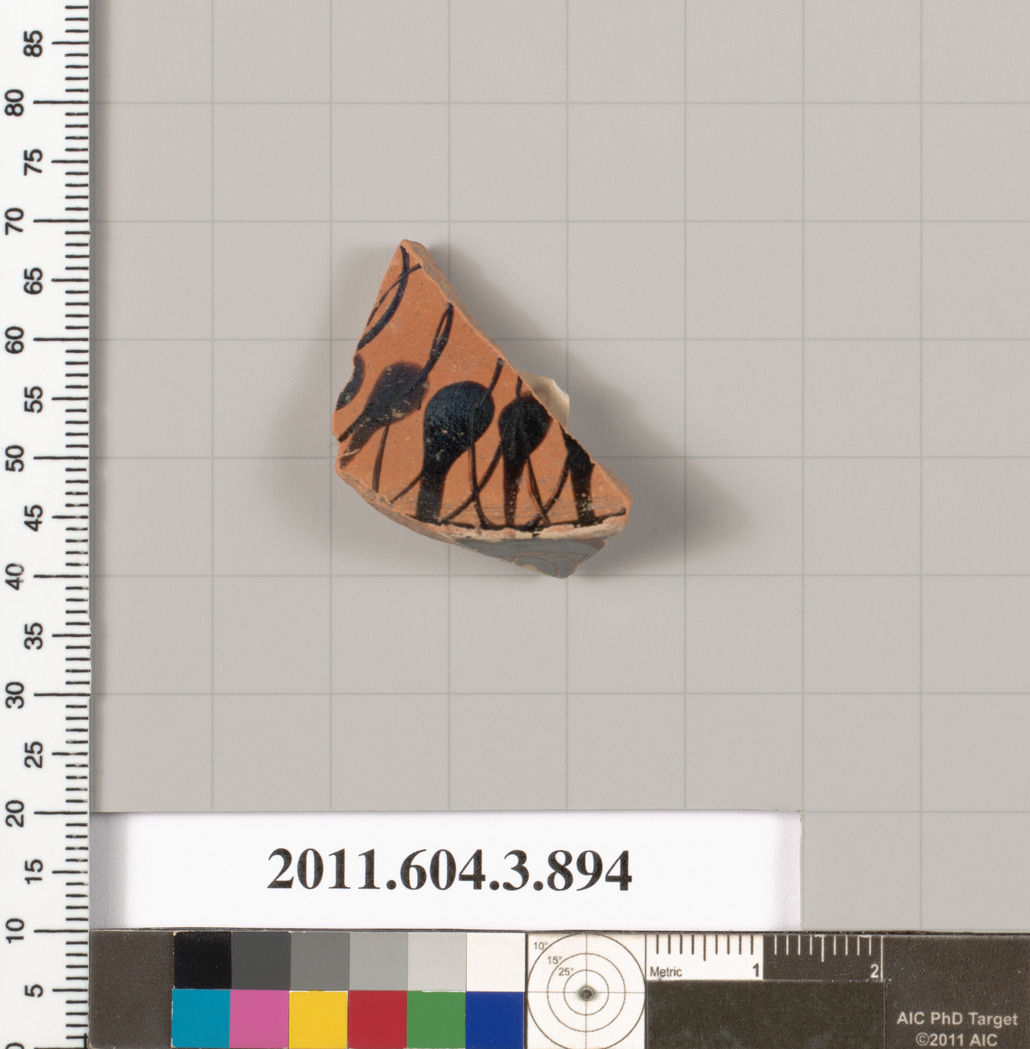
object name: lekythos fragment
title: Terracotta fragment of a lekythos (oil flask)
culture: greek, attic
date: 534-501 BCE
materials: terracotta